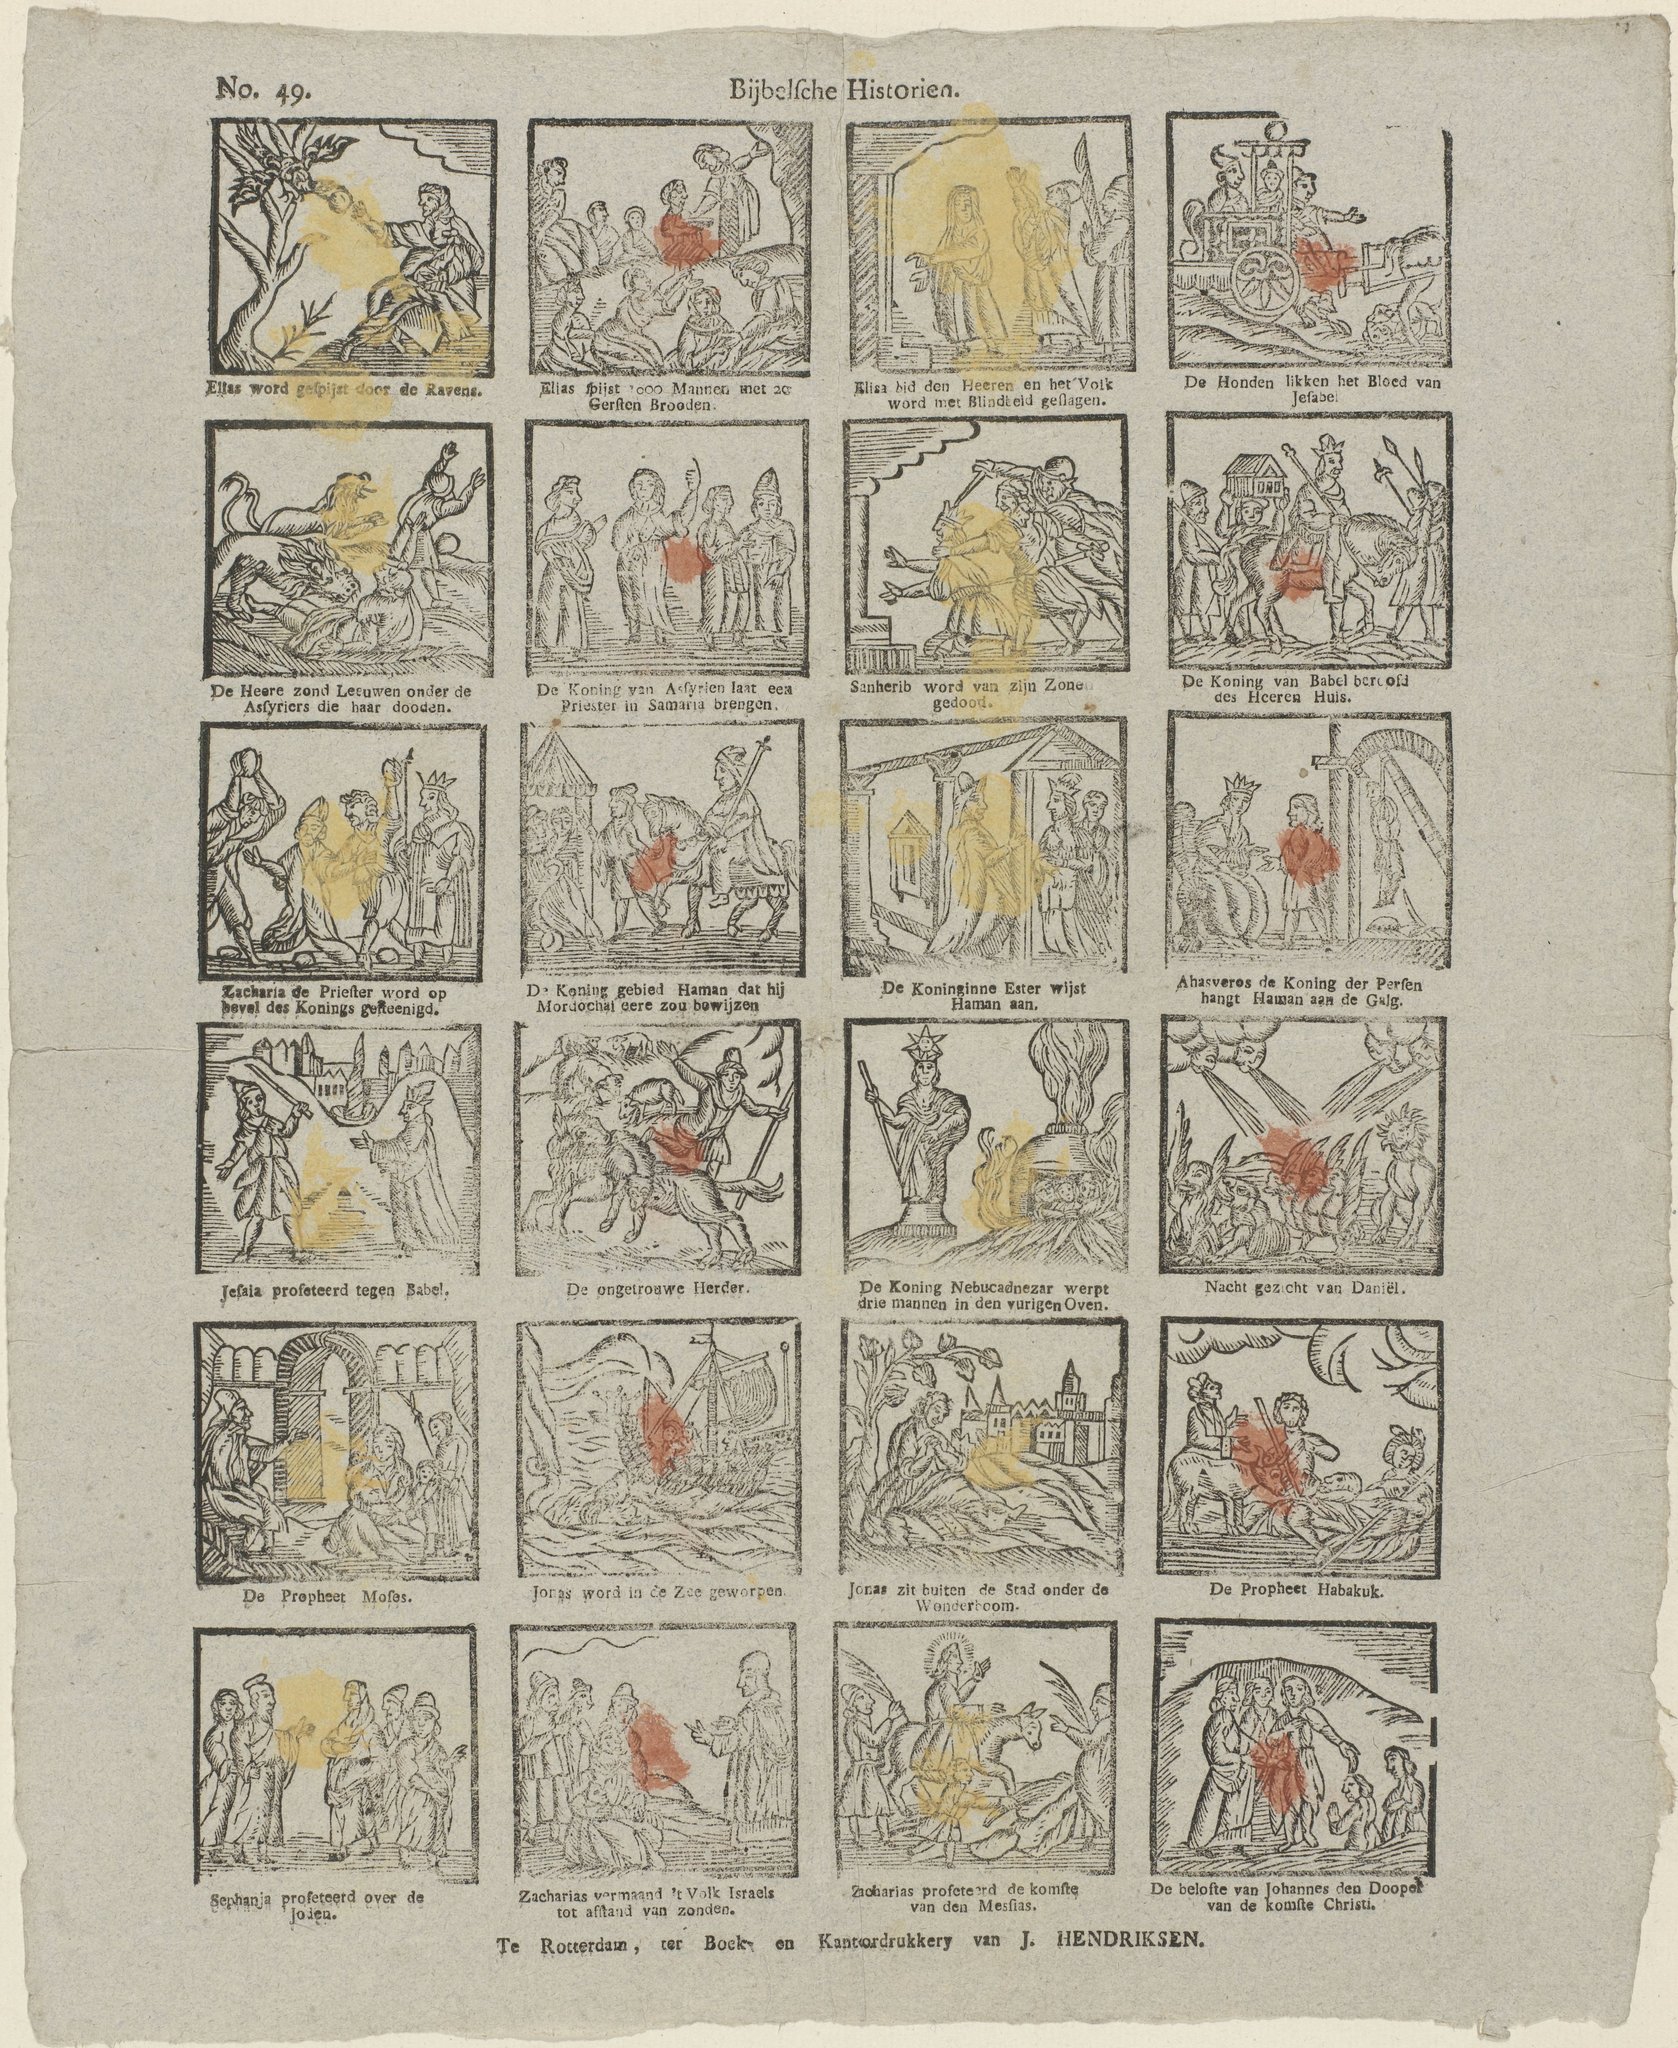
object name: print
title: Bijbelsche historien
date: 1781-1828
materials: paper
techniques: colour, letterpress printing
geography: rotterdam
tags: when sennacherib is worshipping in the temple, two of his sons kill him with their swords, the story of the three hebrews in the fiery furnace (daniel 3), old testament, dogs eat jezebel's body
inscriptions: collector's mark: Lugt 2228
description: Blad met 24 voorstellingen uit het Oude Testament, zoals de honden die het bloed likken van Izebel, Sanherib die door zijn zonen wordt gedood en koning Nebukadnessar die drie mannen in de vuuroven werpt. Onder elke afbeelding een onderschrift. Genummerd linksboven: No. 49.